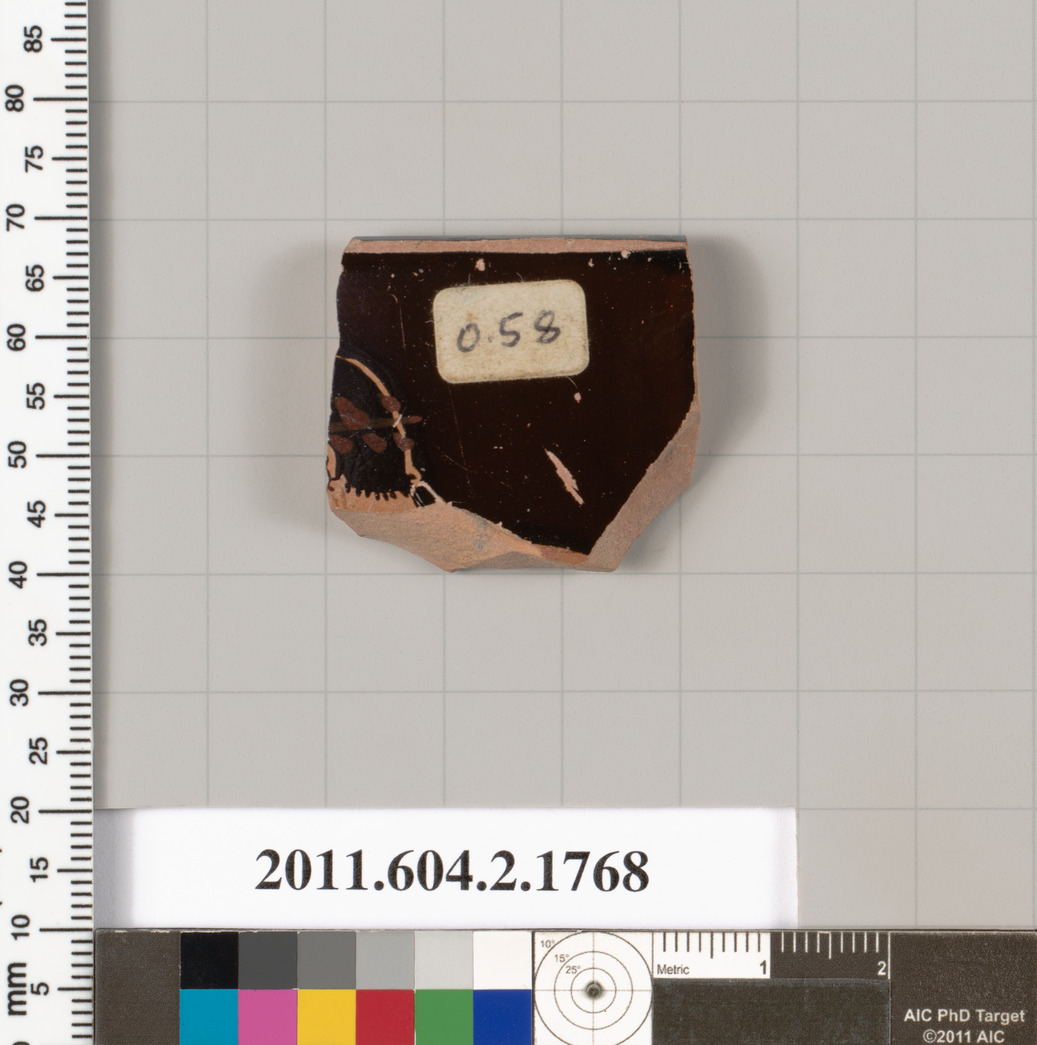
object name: skyphos fragment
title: Terracotta rim fragment of a skyphos (deep drinking cup)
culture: greek, attic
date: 475-451 BCE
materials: terracotta